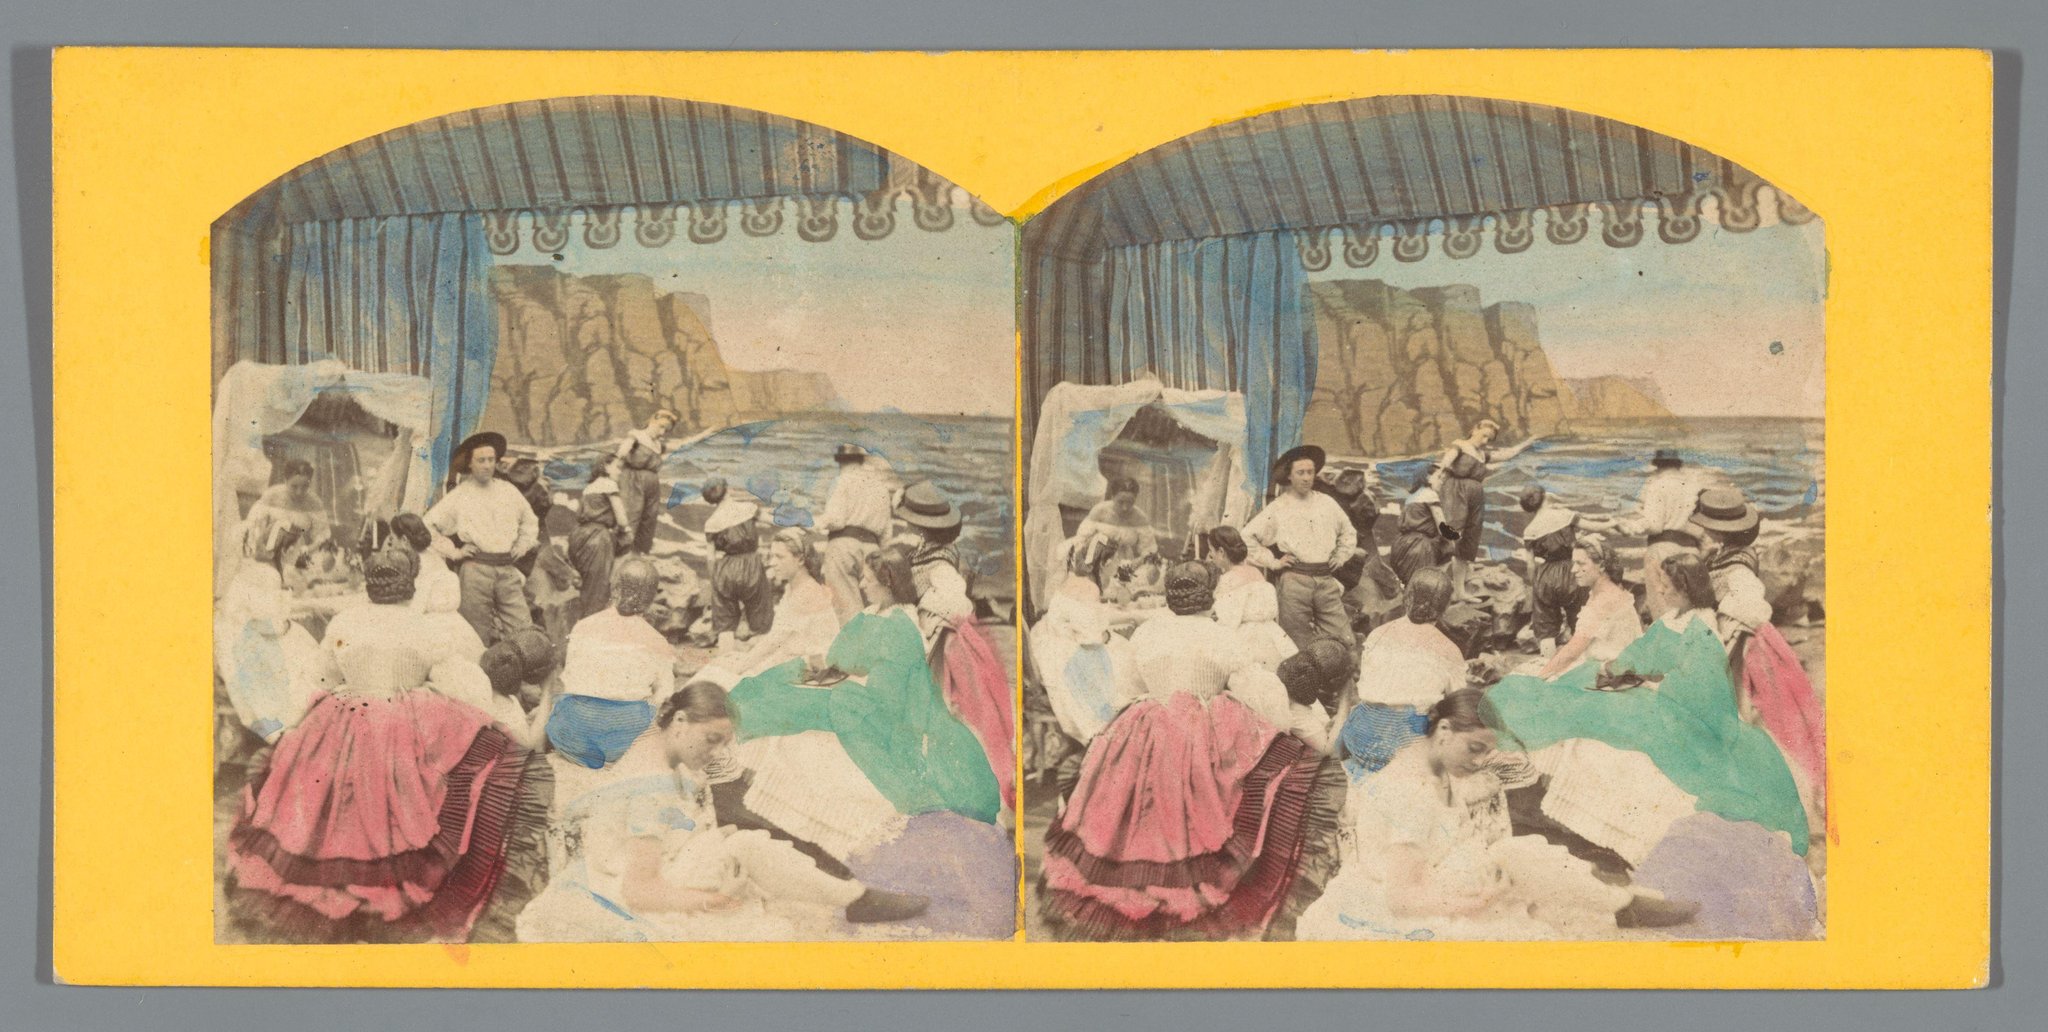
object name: stereograph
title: Vrouwen gekleed in badpak voor een decor met een zeegezicht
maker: Anonymous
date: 1858-1870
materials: cardboard, paper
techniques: albumen print, hand coloring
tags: set, scenery ~ stage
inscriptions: inscription: ‘Cg/70’, inscription: ‘No 54’, inscription: ‘9’